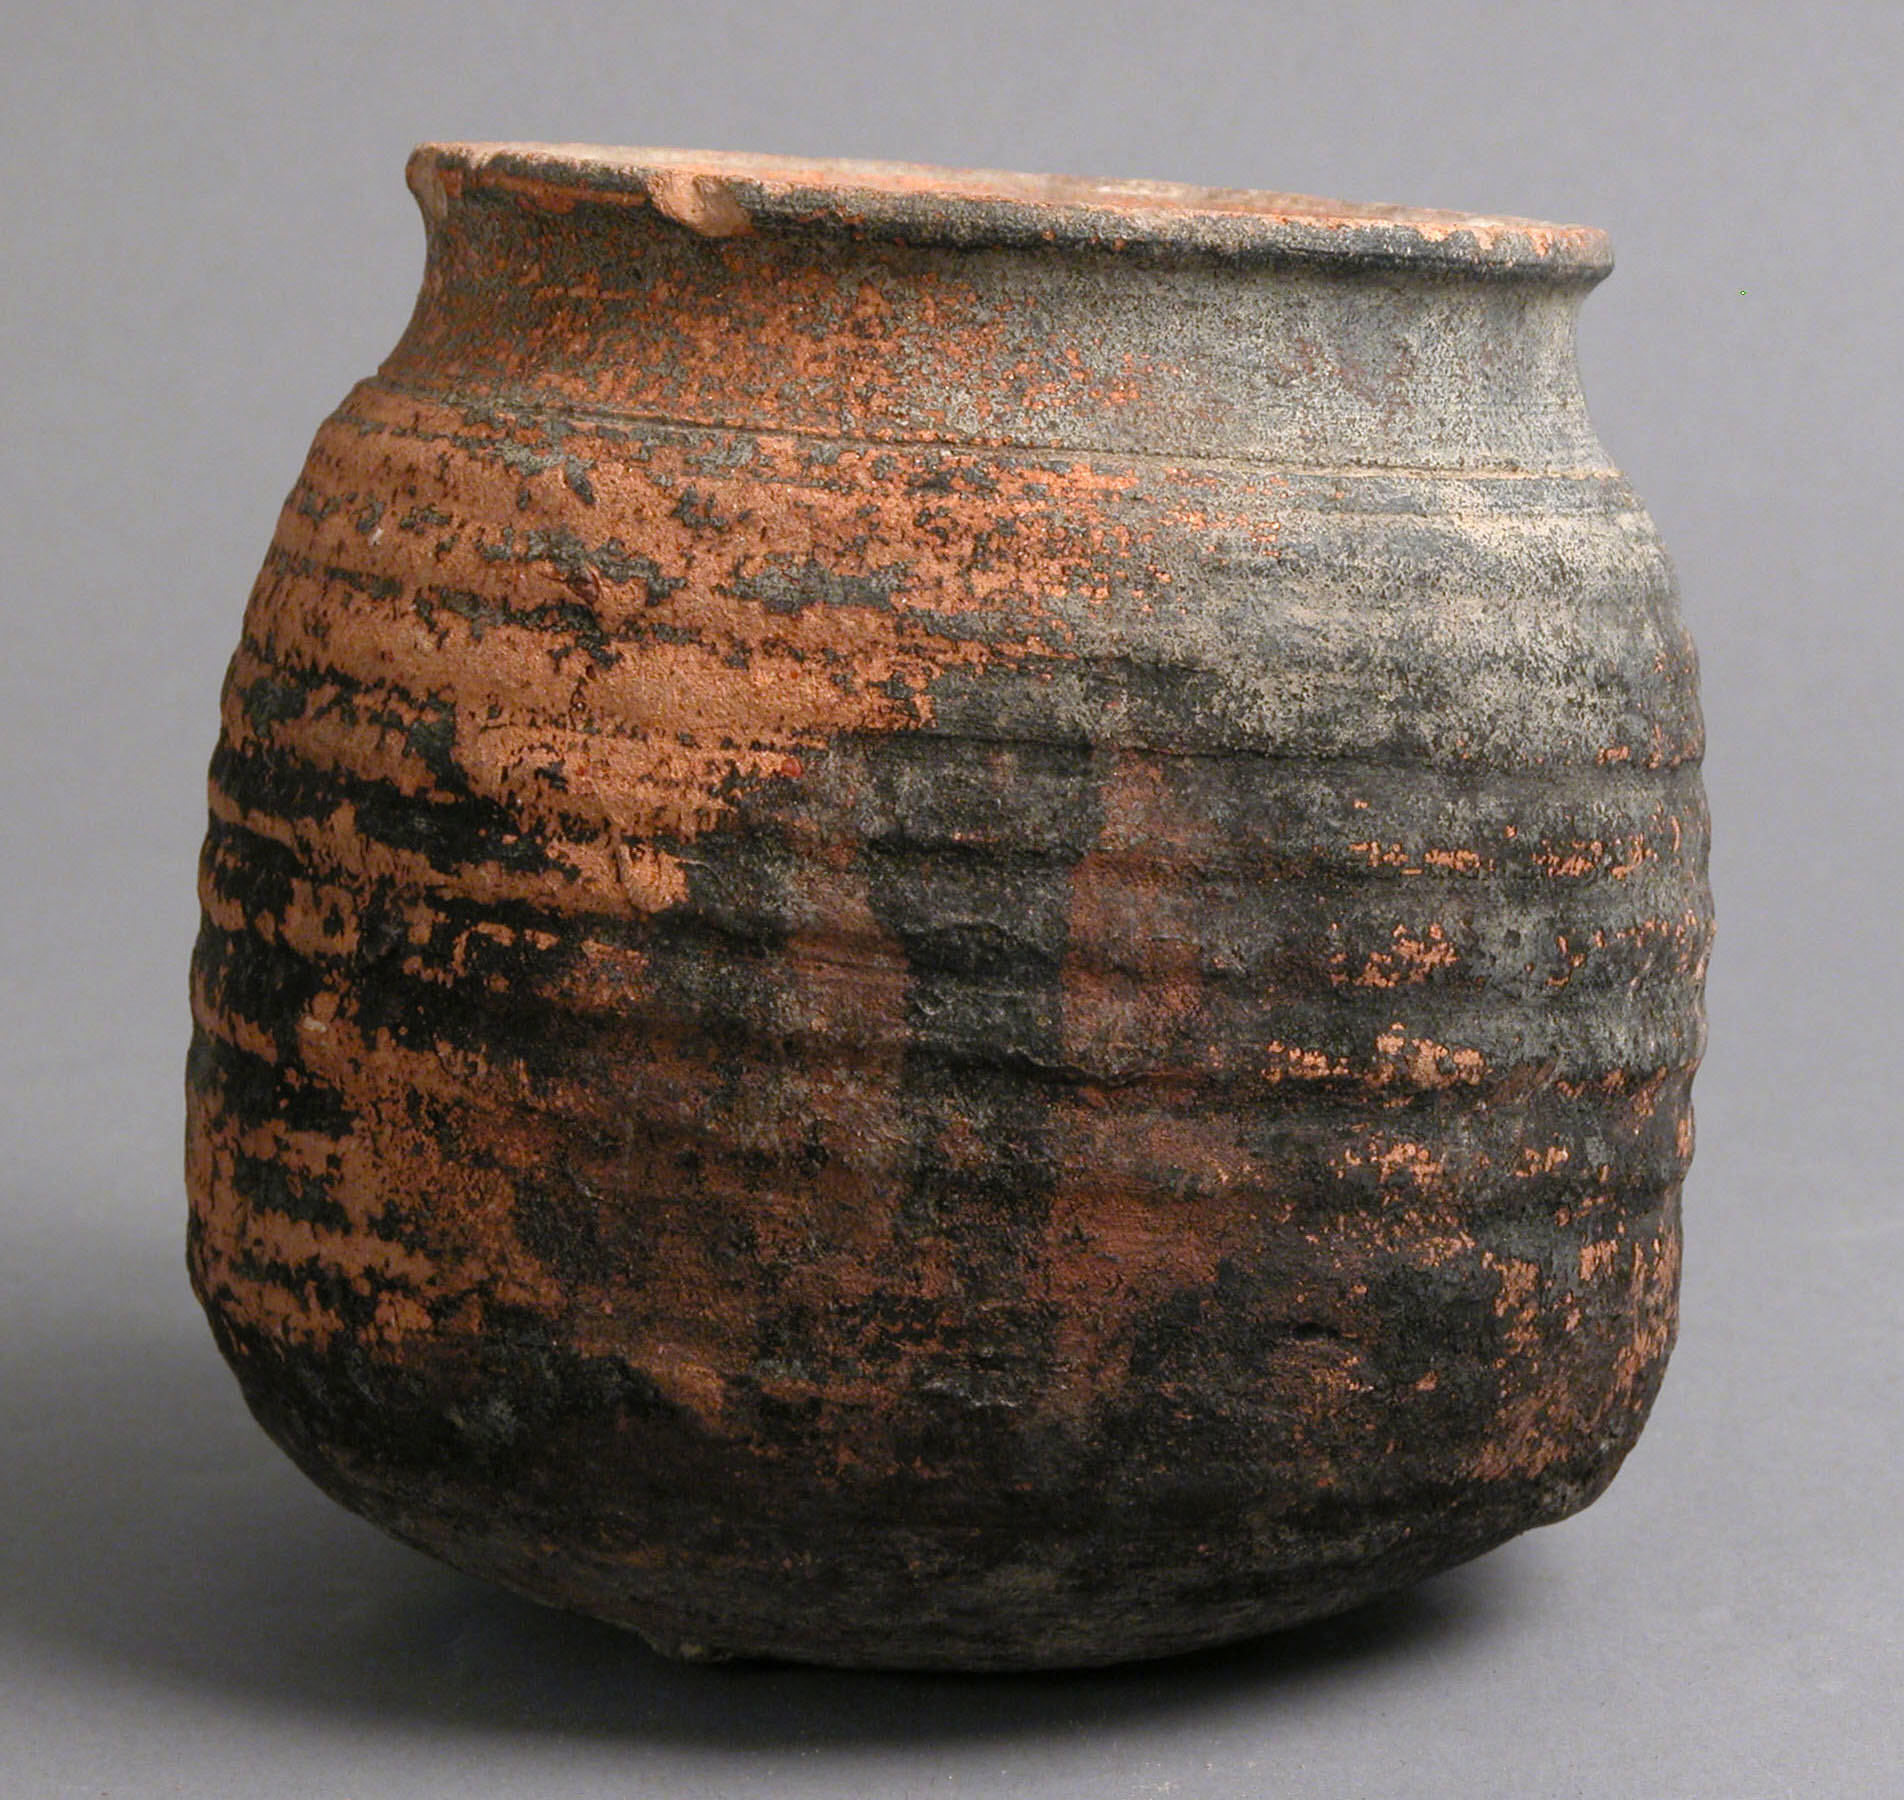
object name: pot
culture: coptic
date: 301-700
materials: earthenware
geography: egypt